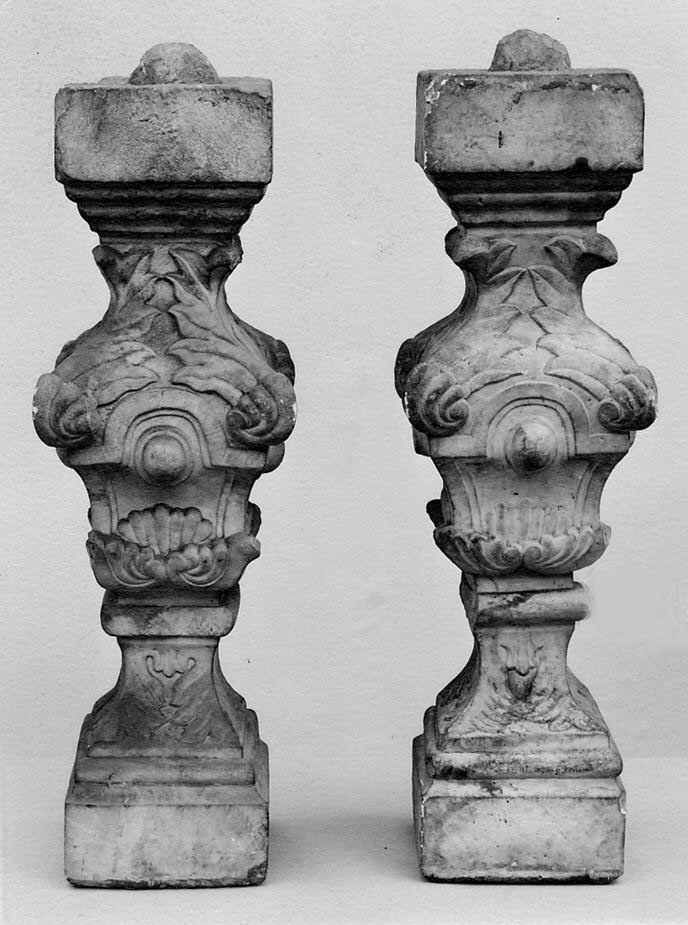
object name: baluster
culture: chinese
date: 1601-1800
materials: marble